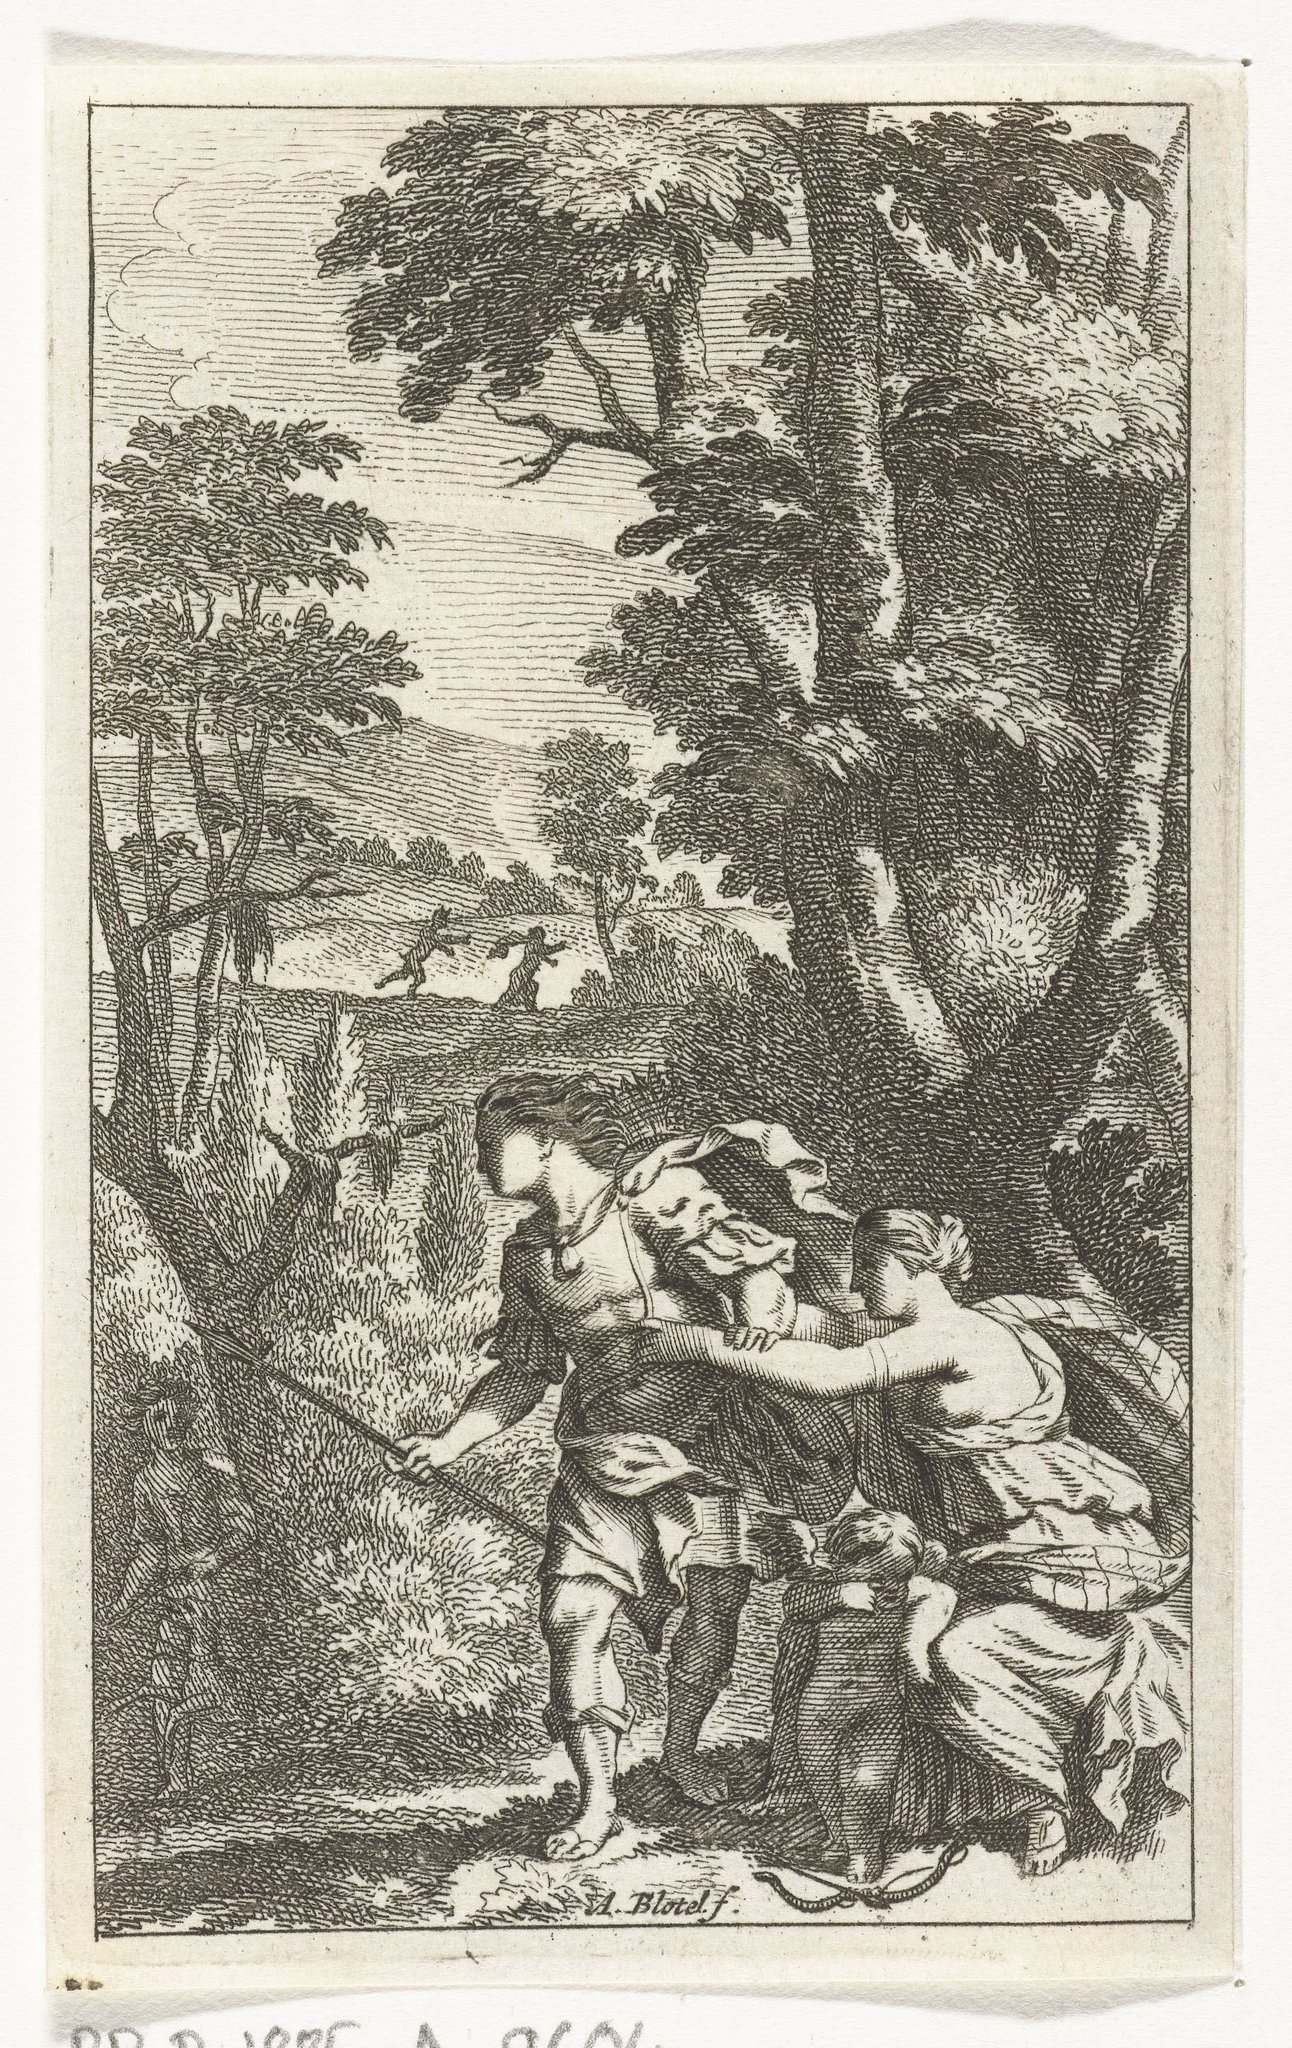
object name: book illustration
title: Vluchtende herder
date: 1677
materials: paper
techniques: engraving, etching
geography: cologne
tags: (scenes from) specific works of literature: guarini, pastor fido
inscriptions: collector's mark: Lugt 2228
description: Boekillustratie uit een Italiaanse of Franse editie van G.B. Guarini, Il pastor fido. Mogelijk uit de Franse editie: Le berger fidele, Keulen, P. Marteau, 1677 (fictief adres, eigenlijk gedrukt te Leiden bij de gebroeders Hackius).